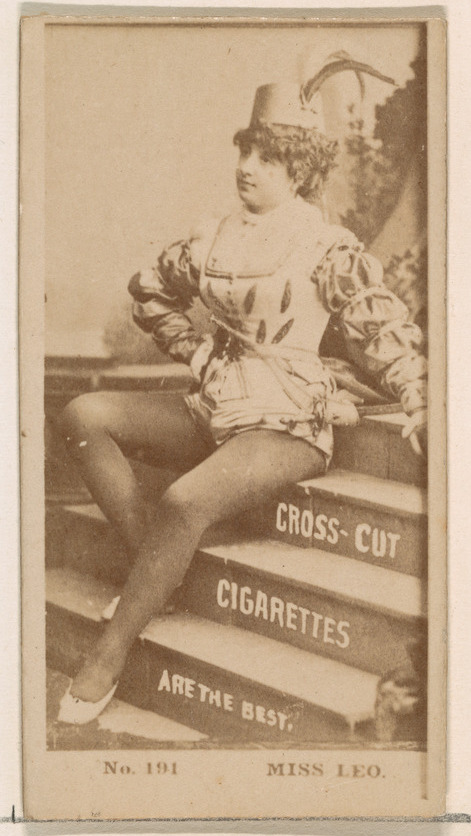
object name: print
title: Card Number 191, Miss Leo, from the Actors and Actresses series (N145-2) issued by Duke Sons & Co. to promote Cross Cut Cigarettes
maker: w. duke, sons & co.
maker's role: publisher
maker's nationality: american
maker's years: 1870-1920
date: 1880-1889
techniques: albumen silver print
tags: portraits,women,actresses